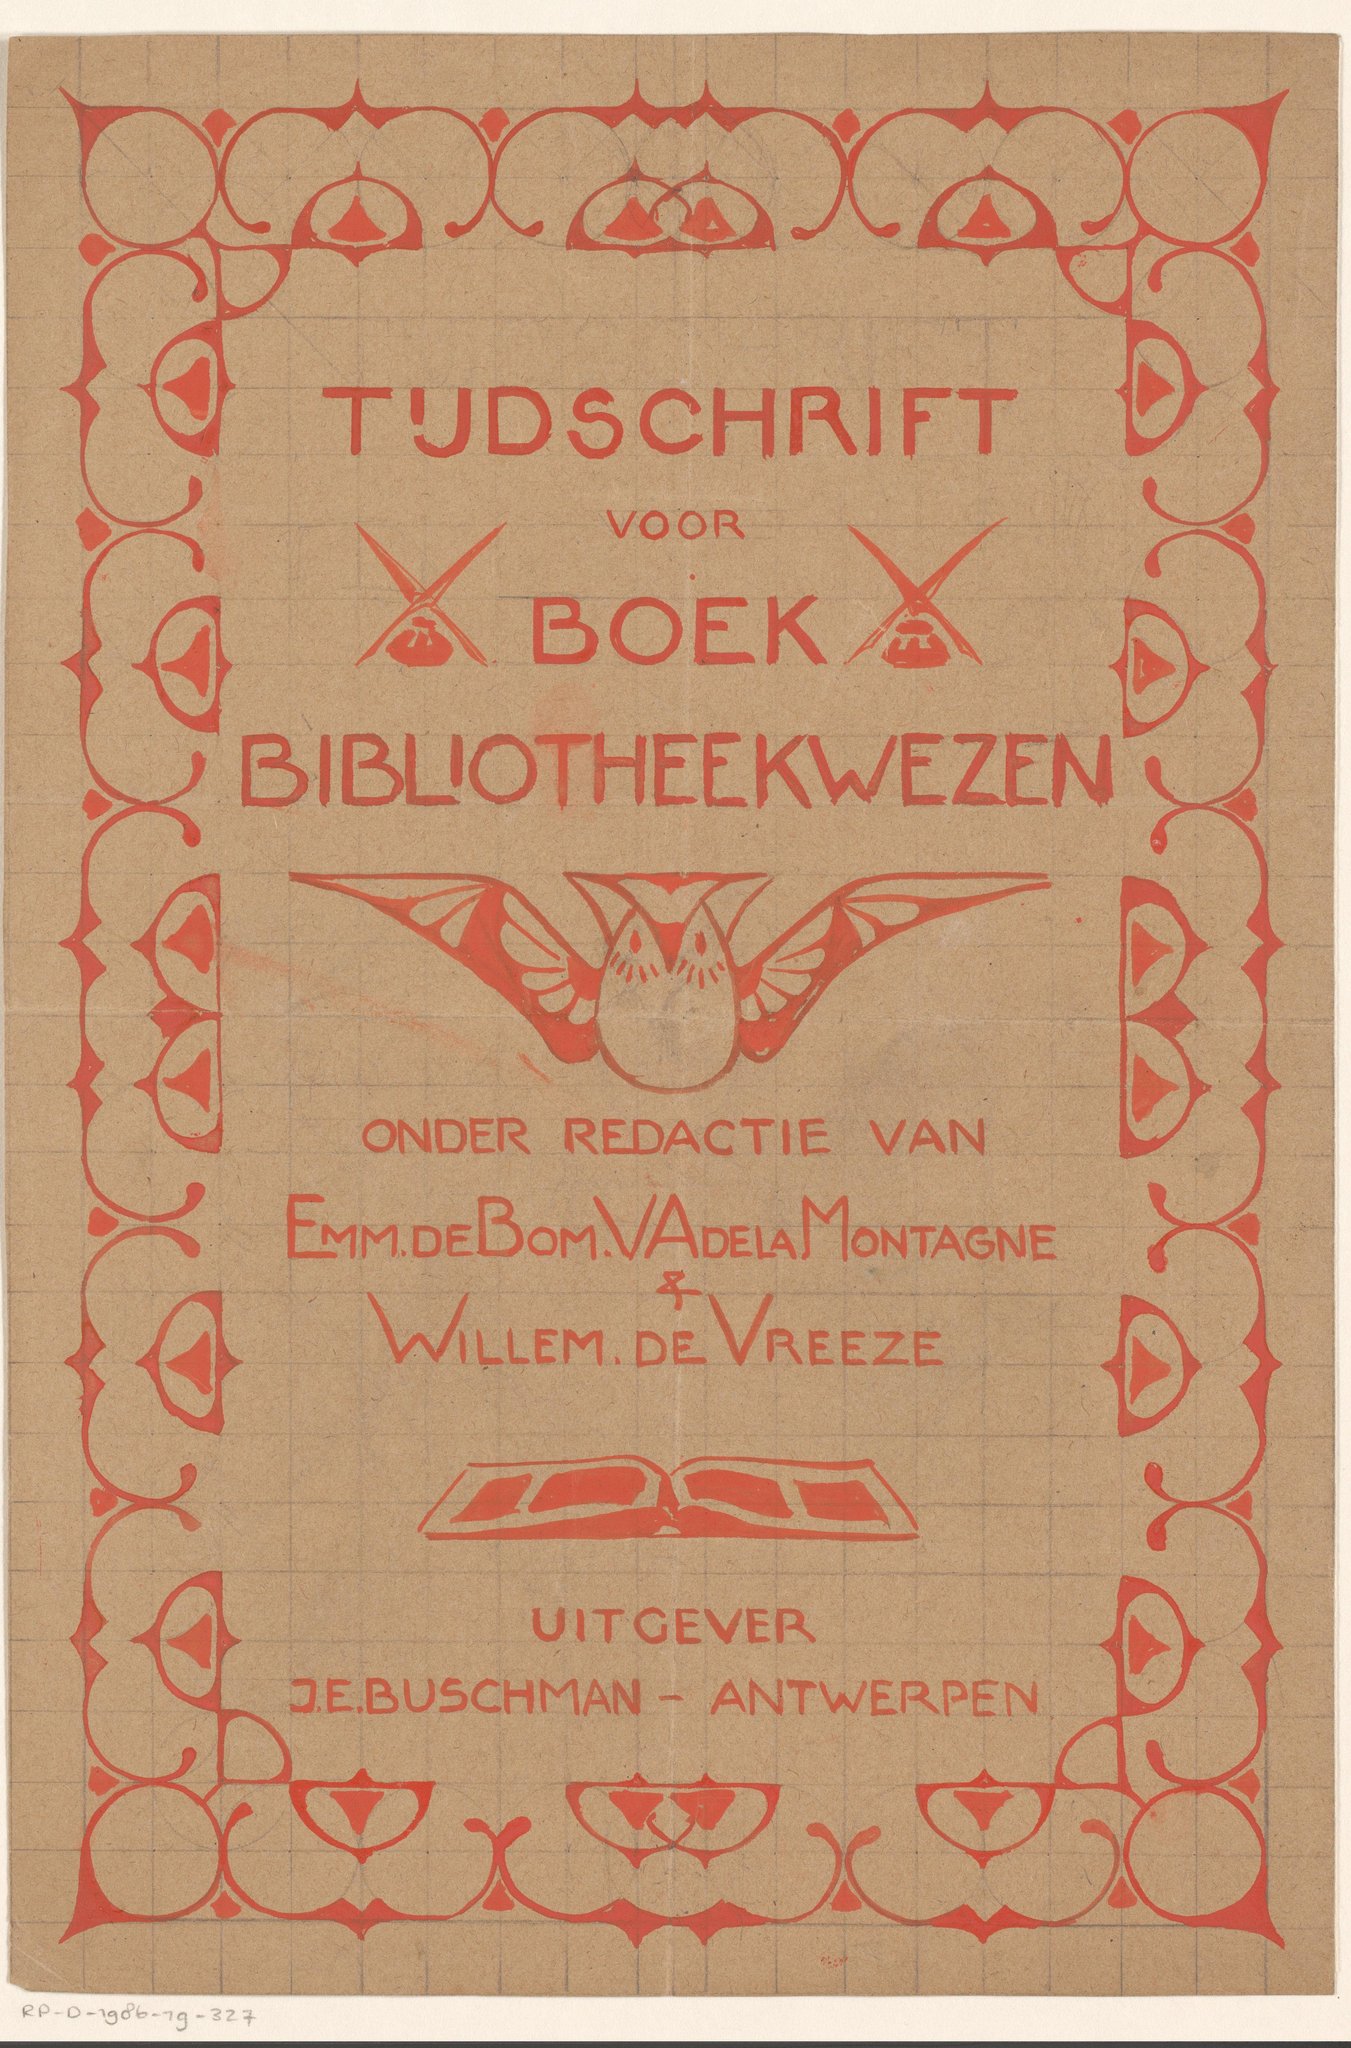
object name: drawing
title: Omslagontwerp voor: Tijdschrift voor boek- en bibliotheekwezen, 1903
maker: reinier willem petrus de vries (1874-1953)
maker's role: draughtsman, print maker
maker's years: 1874-1953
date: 1903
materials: paint, paper, pencil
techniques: brush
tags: book - mm - book open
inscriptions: collector's mark: ‘R:MVS.’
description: Ornamenteel kader en een opengeslagen boek.